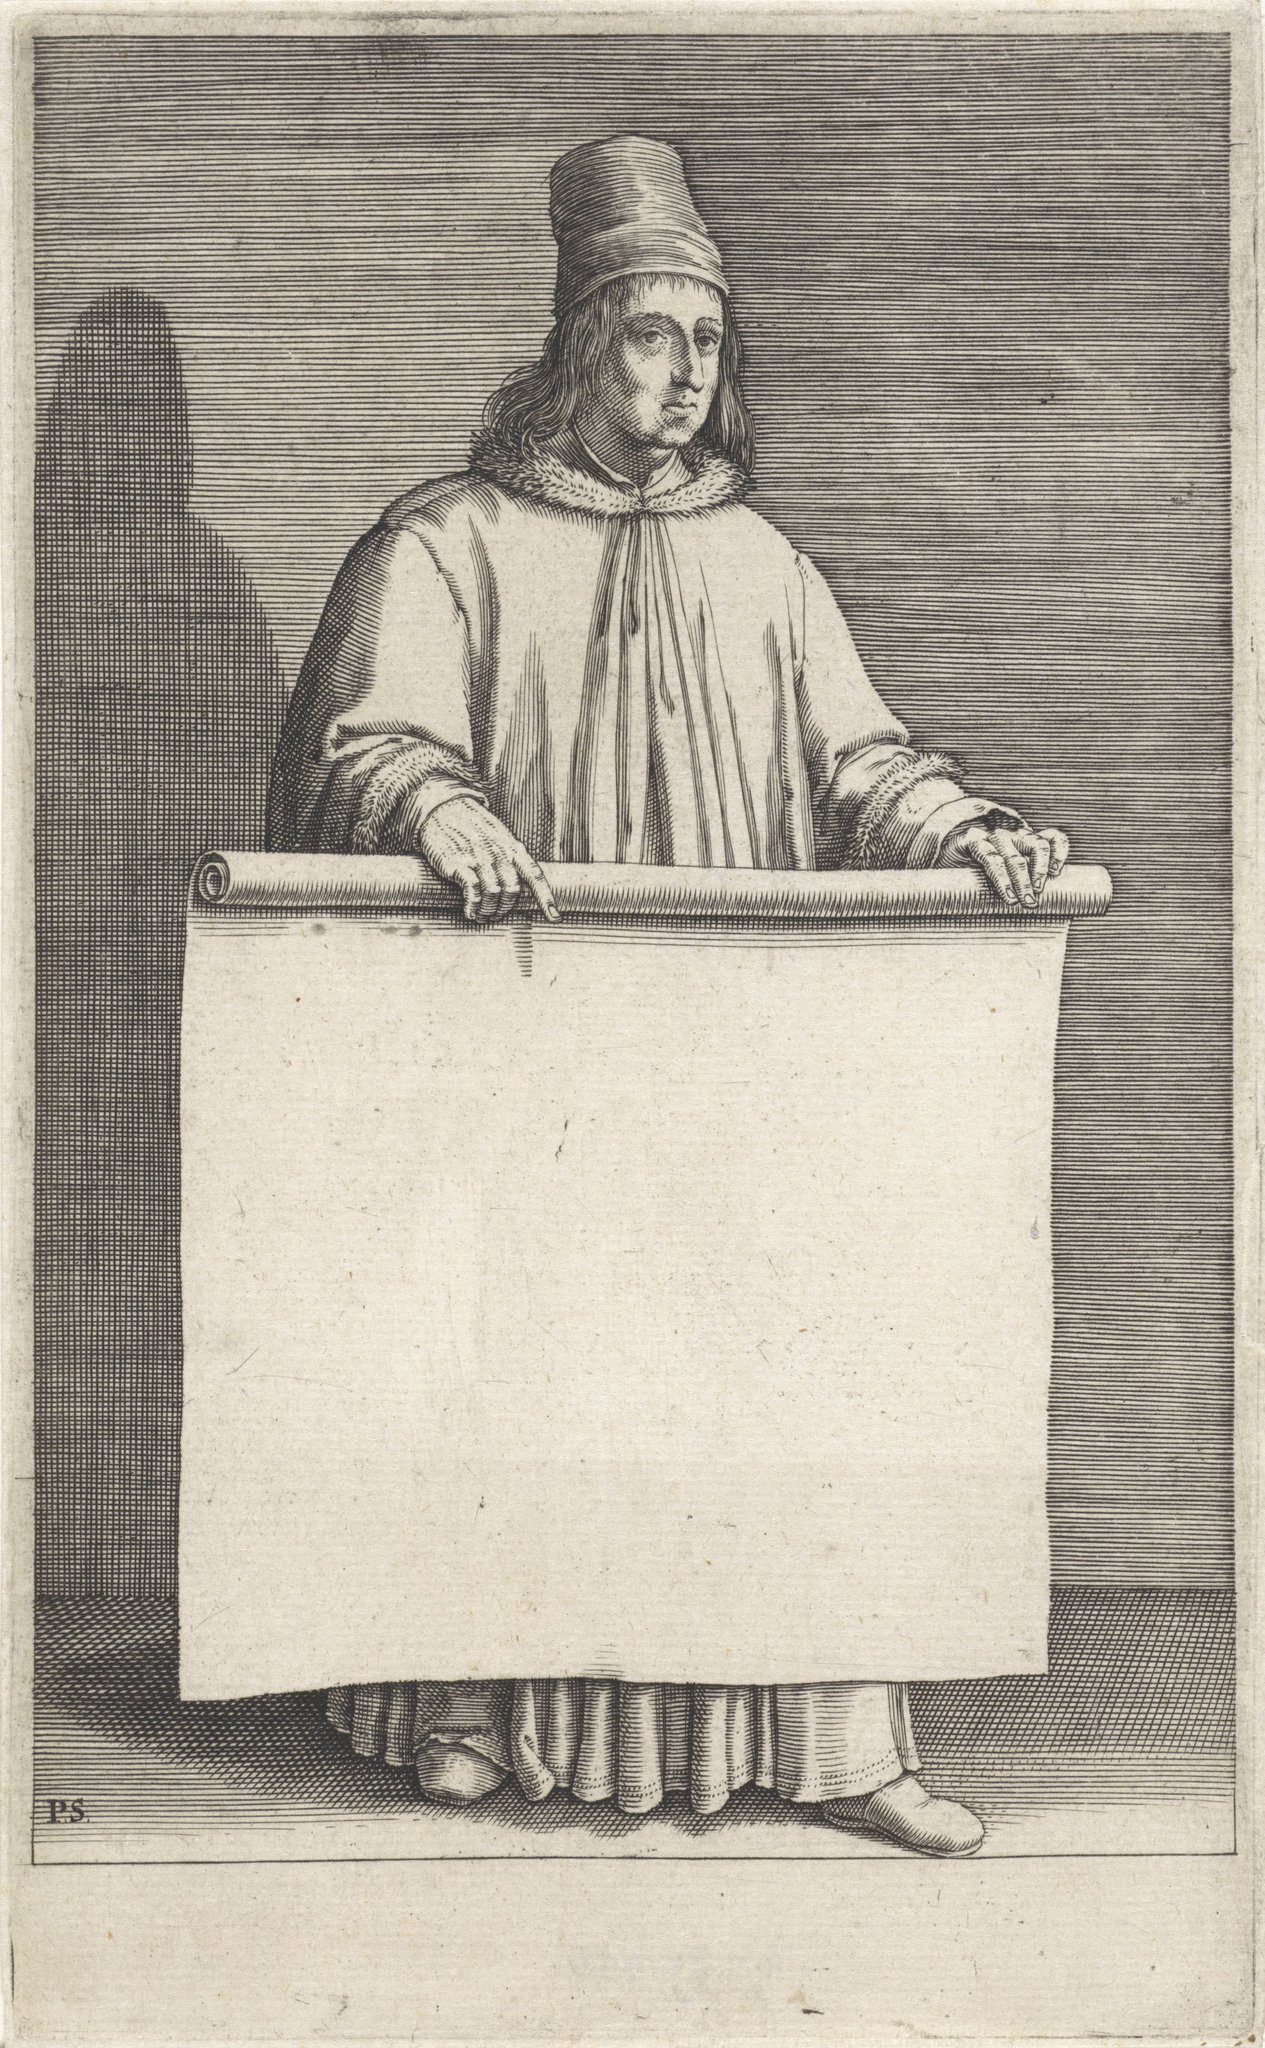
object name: print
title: Jongeman met een rol papier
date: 1601-1657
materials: paper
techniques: engraving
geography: amsterdam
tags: scroll - ll - scroll unfolded, youth, adolescent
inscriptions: collector's mark: Lugt 240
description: Jongeman met een uitgerolde boekrol in de hand. Hij wijst met zijn vinger op het onbeschreven schrijfvlak.